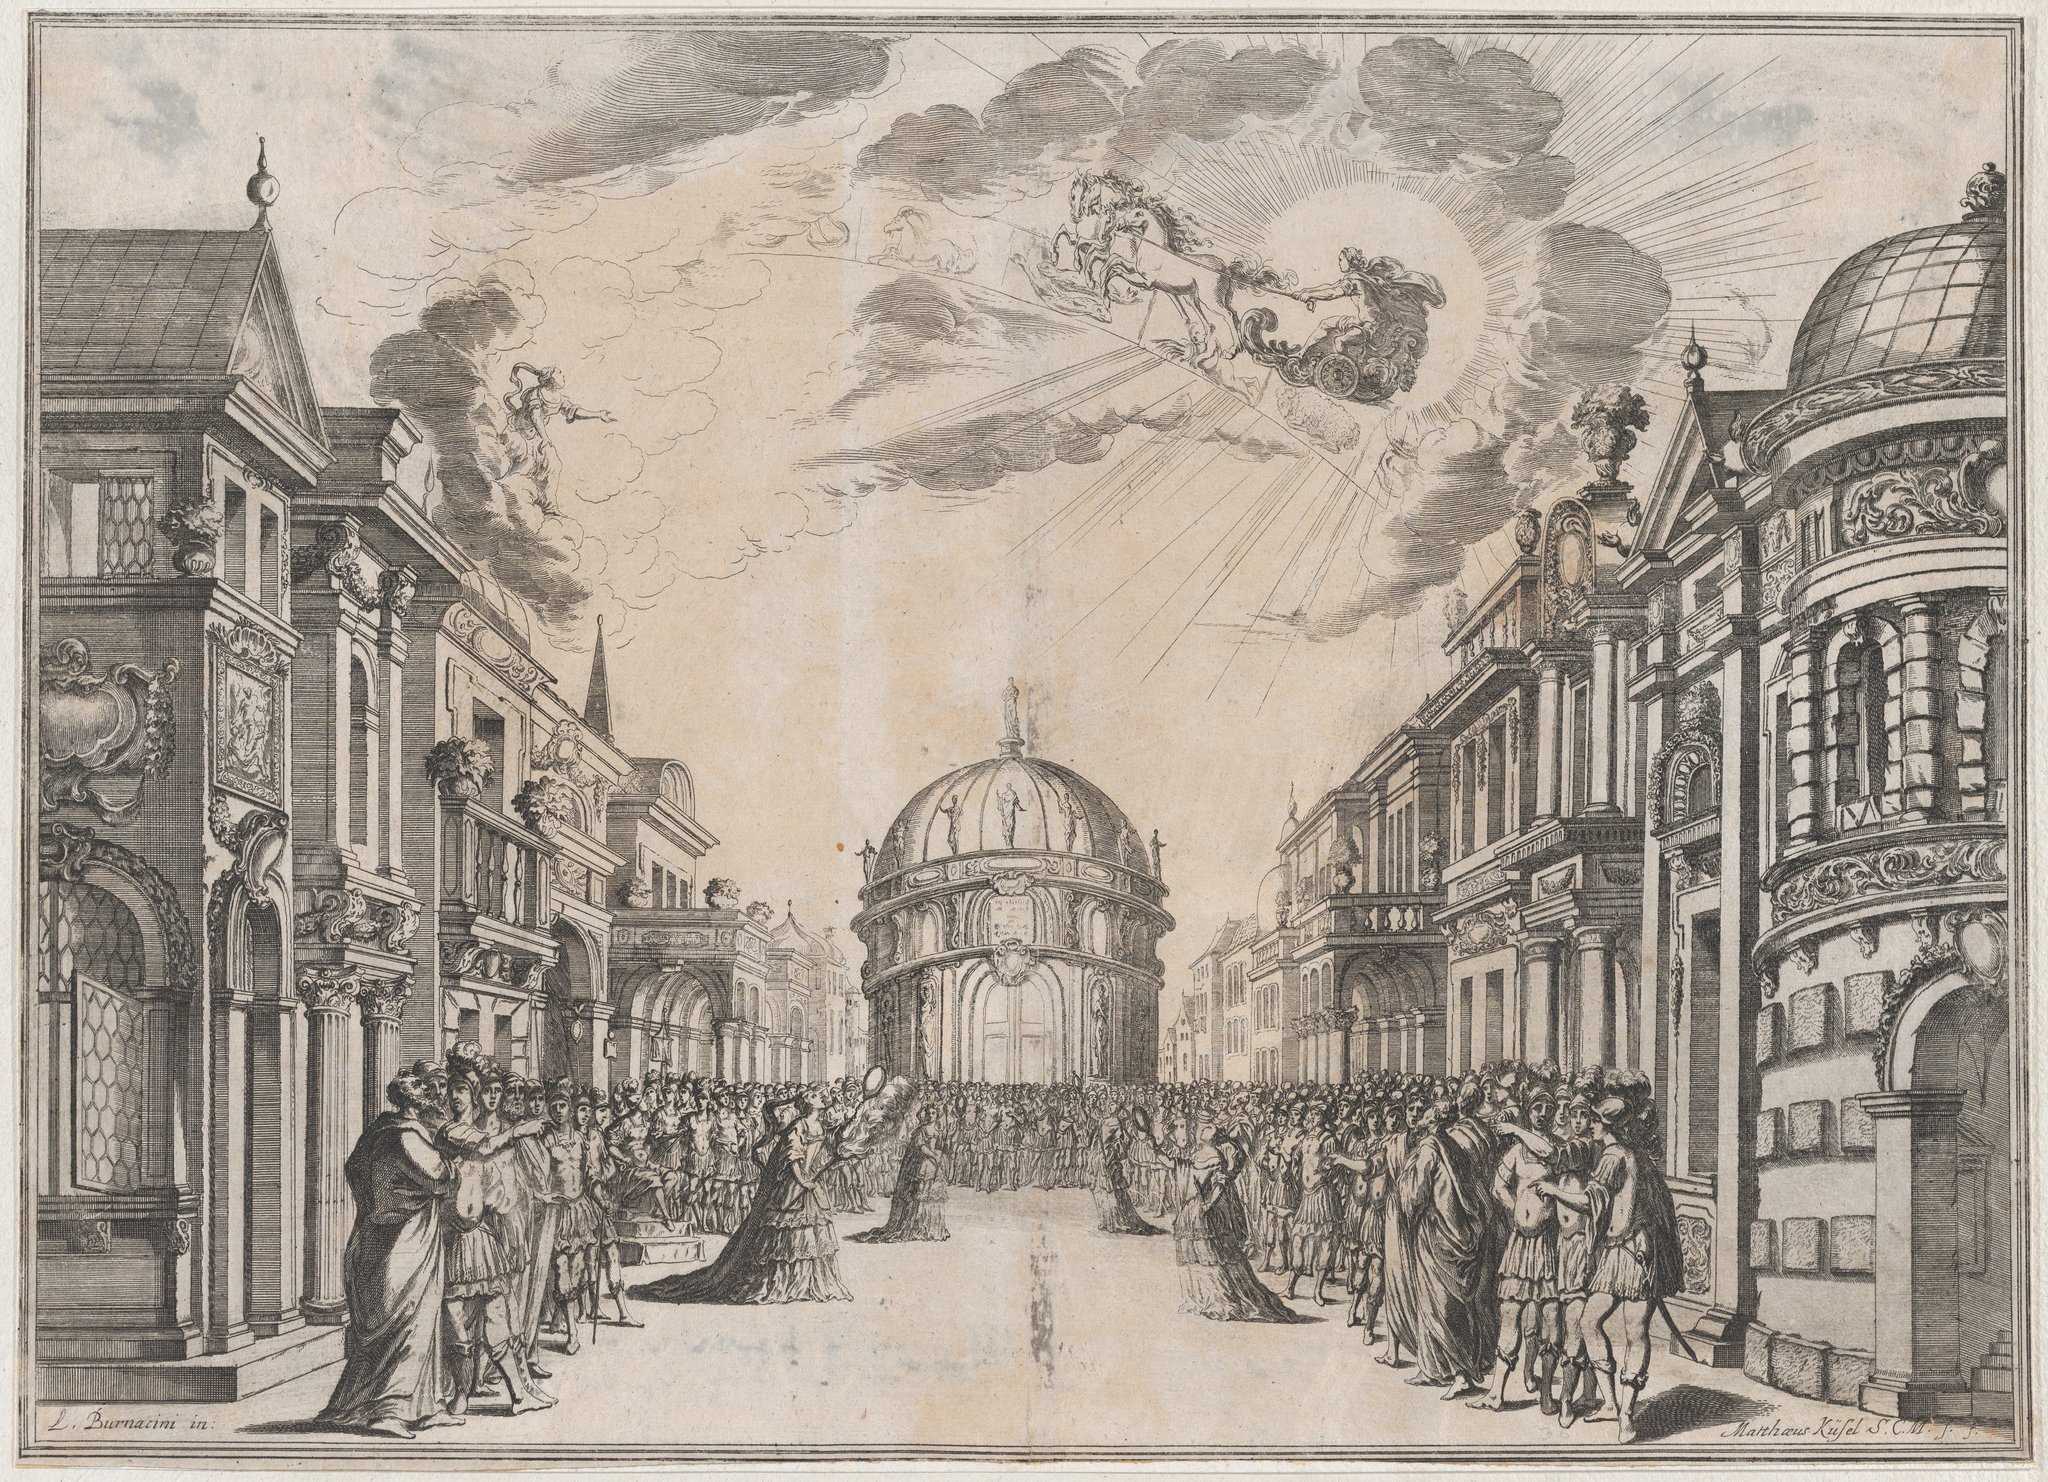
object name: print, fete, ornament architecture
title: A large gathering of people in the street as a goddess races across the sky in a chariot led by four horses; set design from 'Il Fuoco Eterno'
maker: mathäus küsel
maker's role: artist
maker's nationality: german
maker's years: 1621-1682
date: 1674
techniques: etching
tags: opera,horses,goddess,crowd,chariots